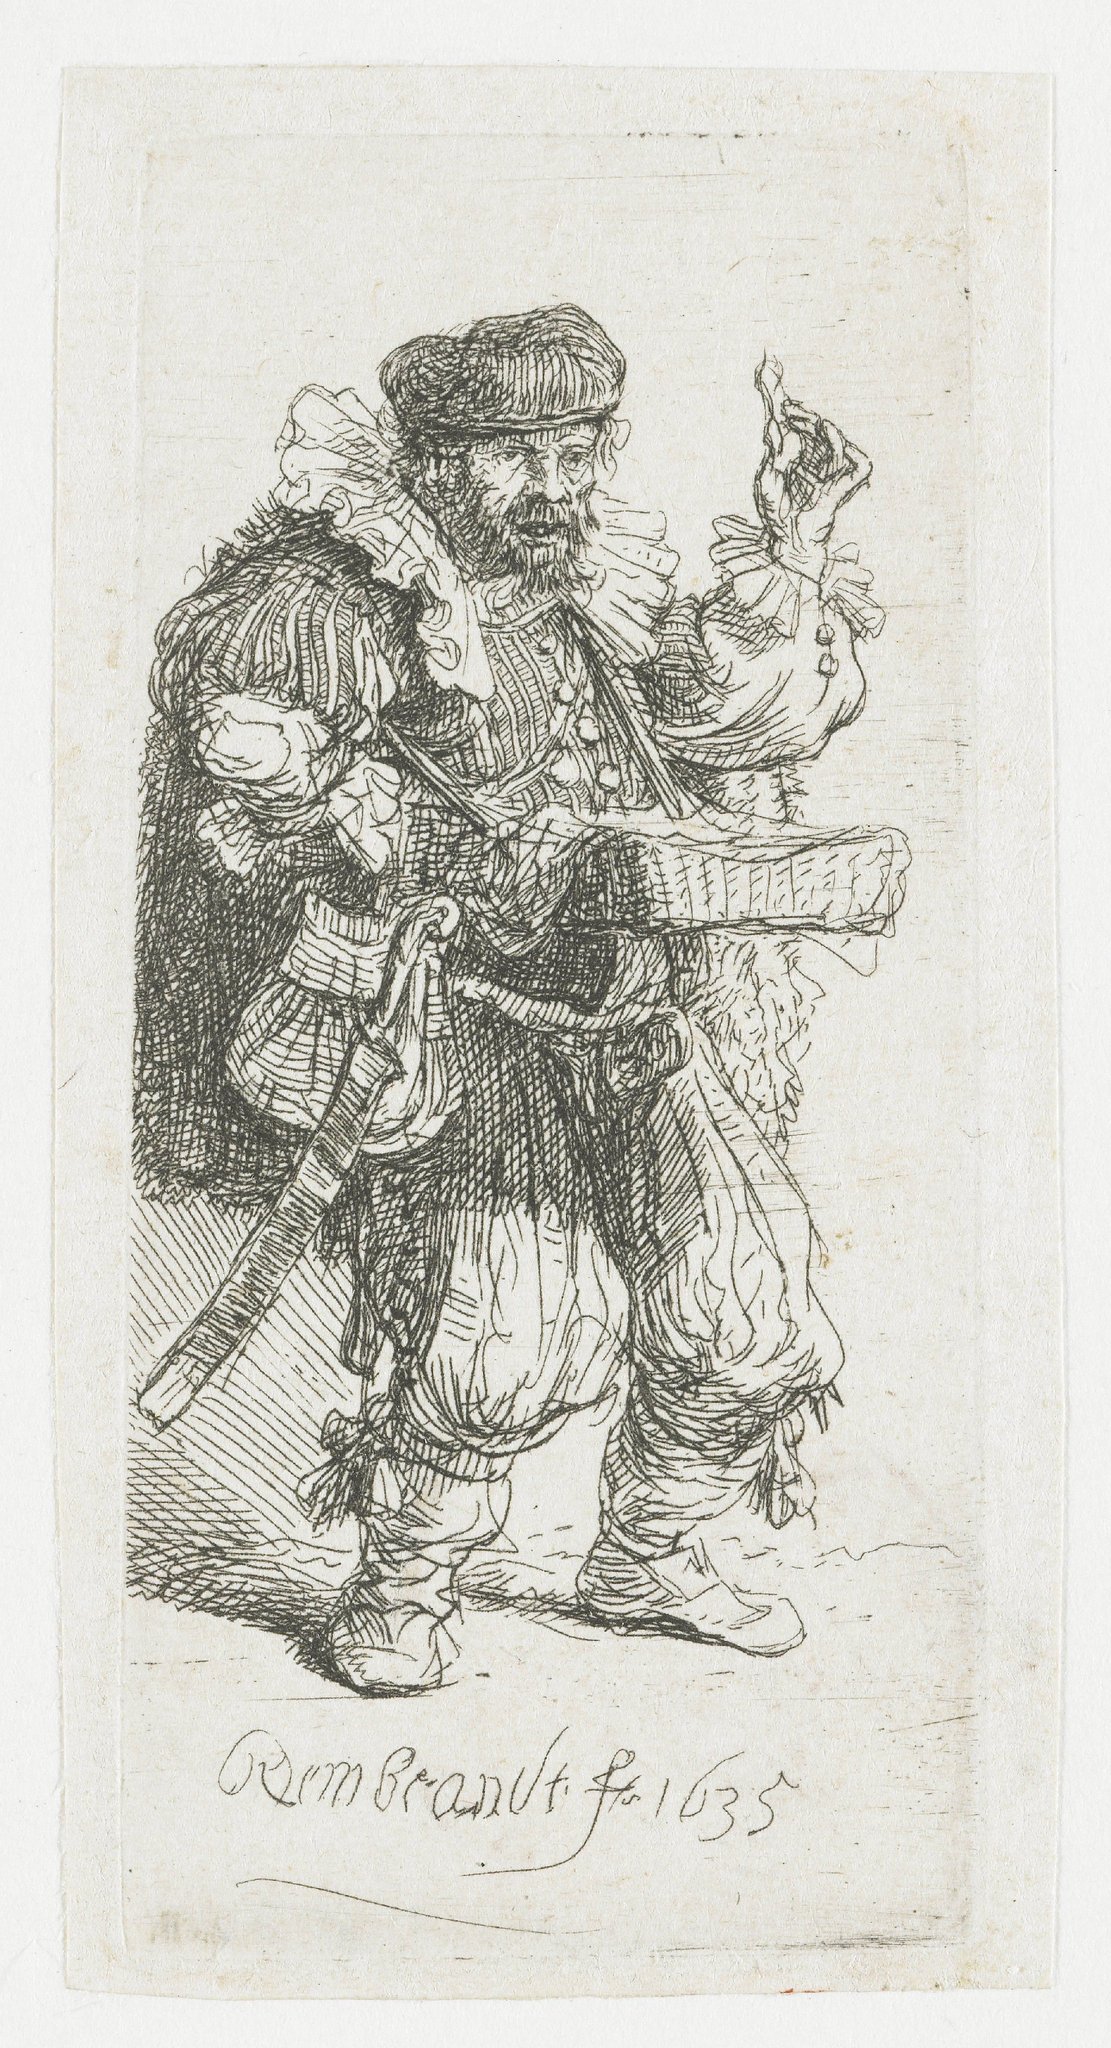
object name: print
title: The quacksalver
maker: rembrandt van rijn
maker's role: draughtsman, painter, print maker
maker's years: 1606-1669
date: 1635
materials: paper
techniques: etching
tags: quack, charlatan, mountebank, 'saltimbanco'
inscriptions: collector's mark: Lugt 240, signature and date: ‘Rembrandt f 1635’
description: Initially, Rembrandt was fascinated above all by pathetic wretches compelled to beg for alms. Later, he also developed an interest in other colourful city folk, which he usually depicted in the same minuscule format. In these six etchings, he portrayed a quack in outmoded clothing, two Polish soldiers, two street musicians (an organ grinder and a fiddler) and a skater.